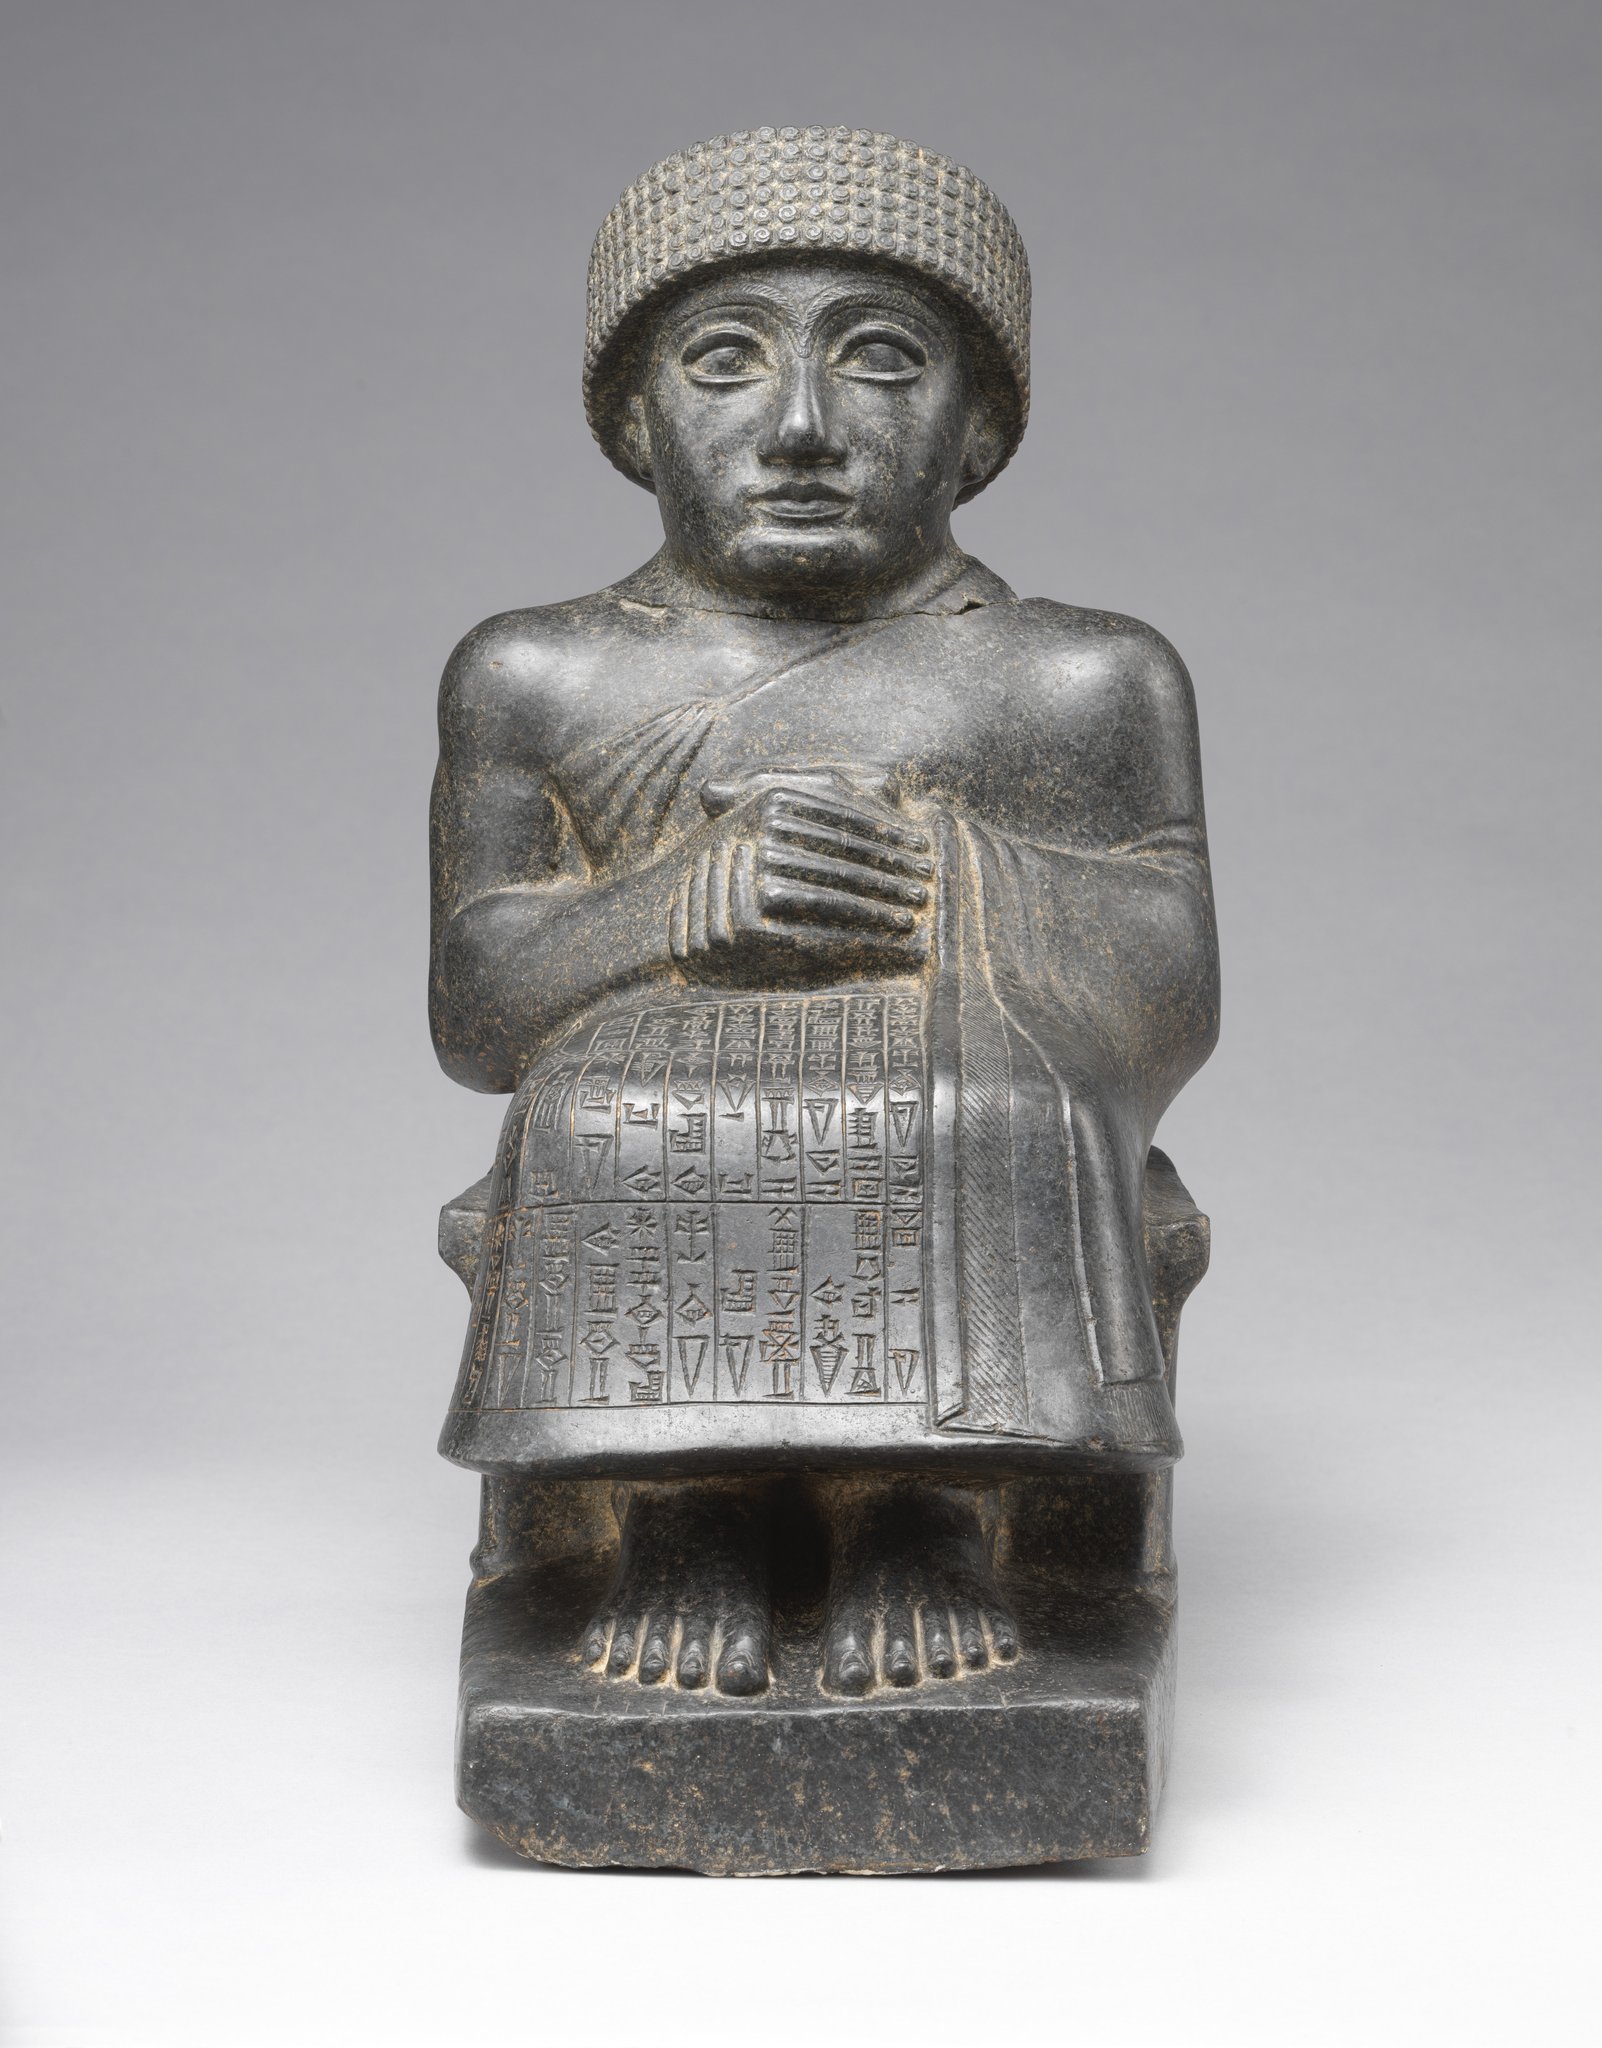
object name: sculpture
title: Statue of Gudea, named “Gudea, the man who built the temple, may his life be long”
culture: neo-sumerian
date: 2090 BCE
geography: mesopotamia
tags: men